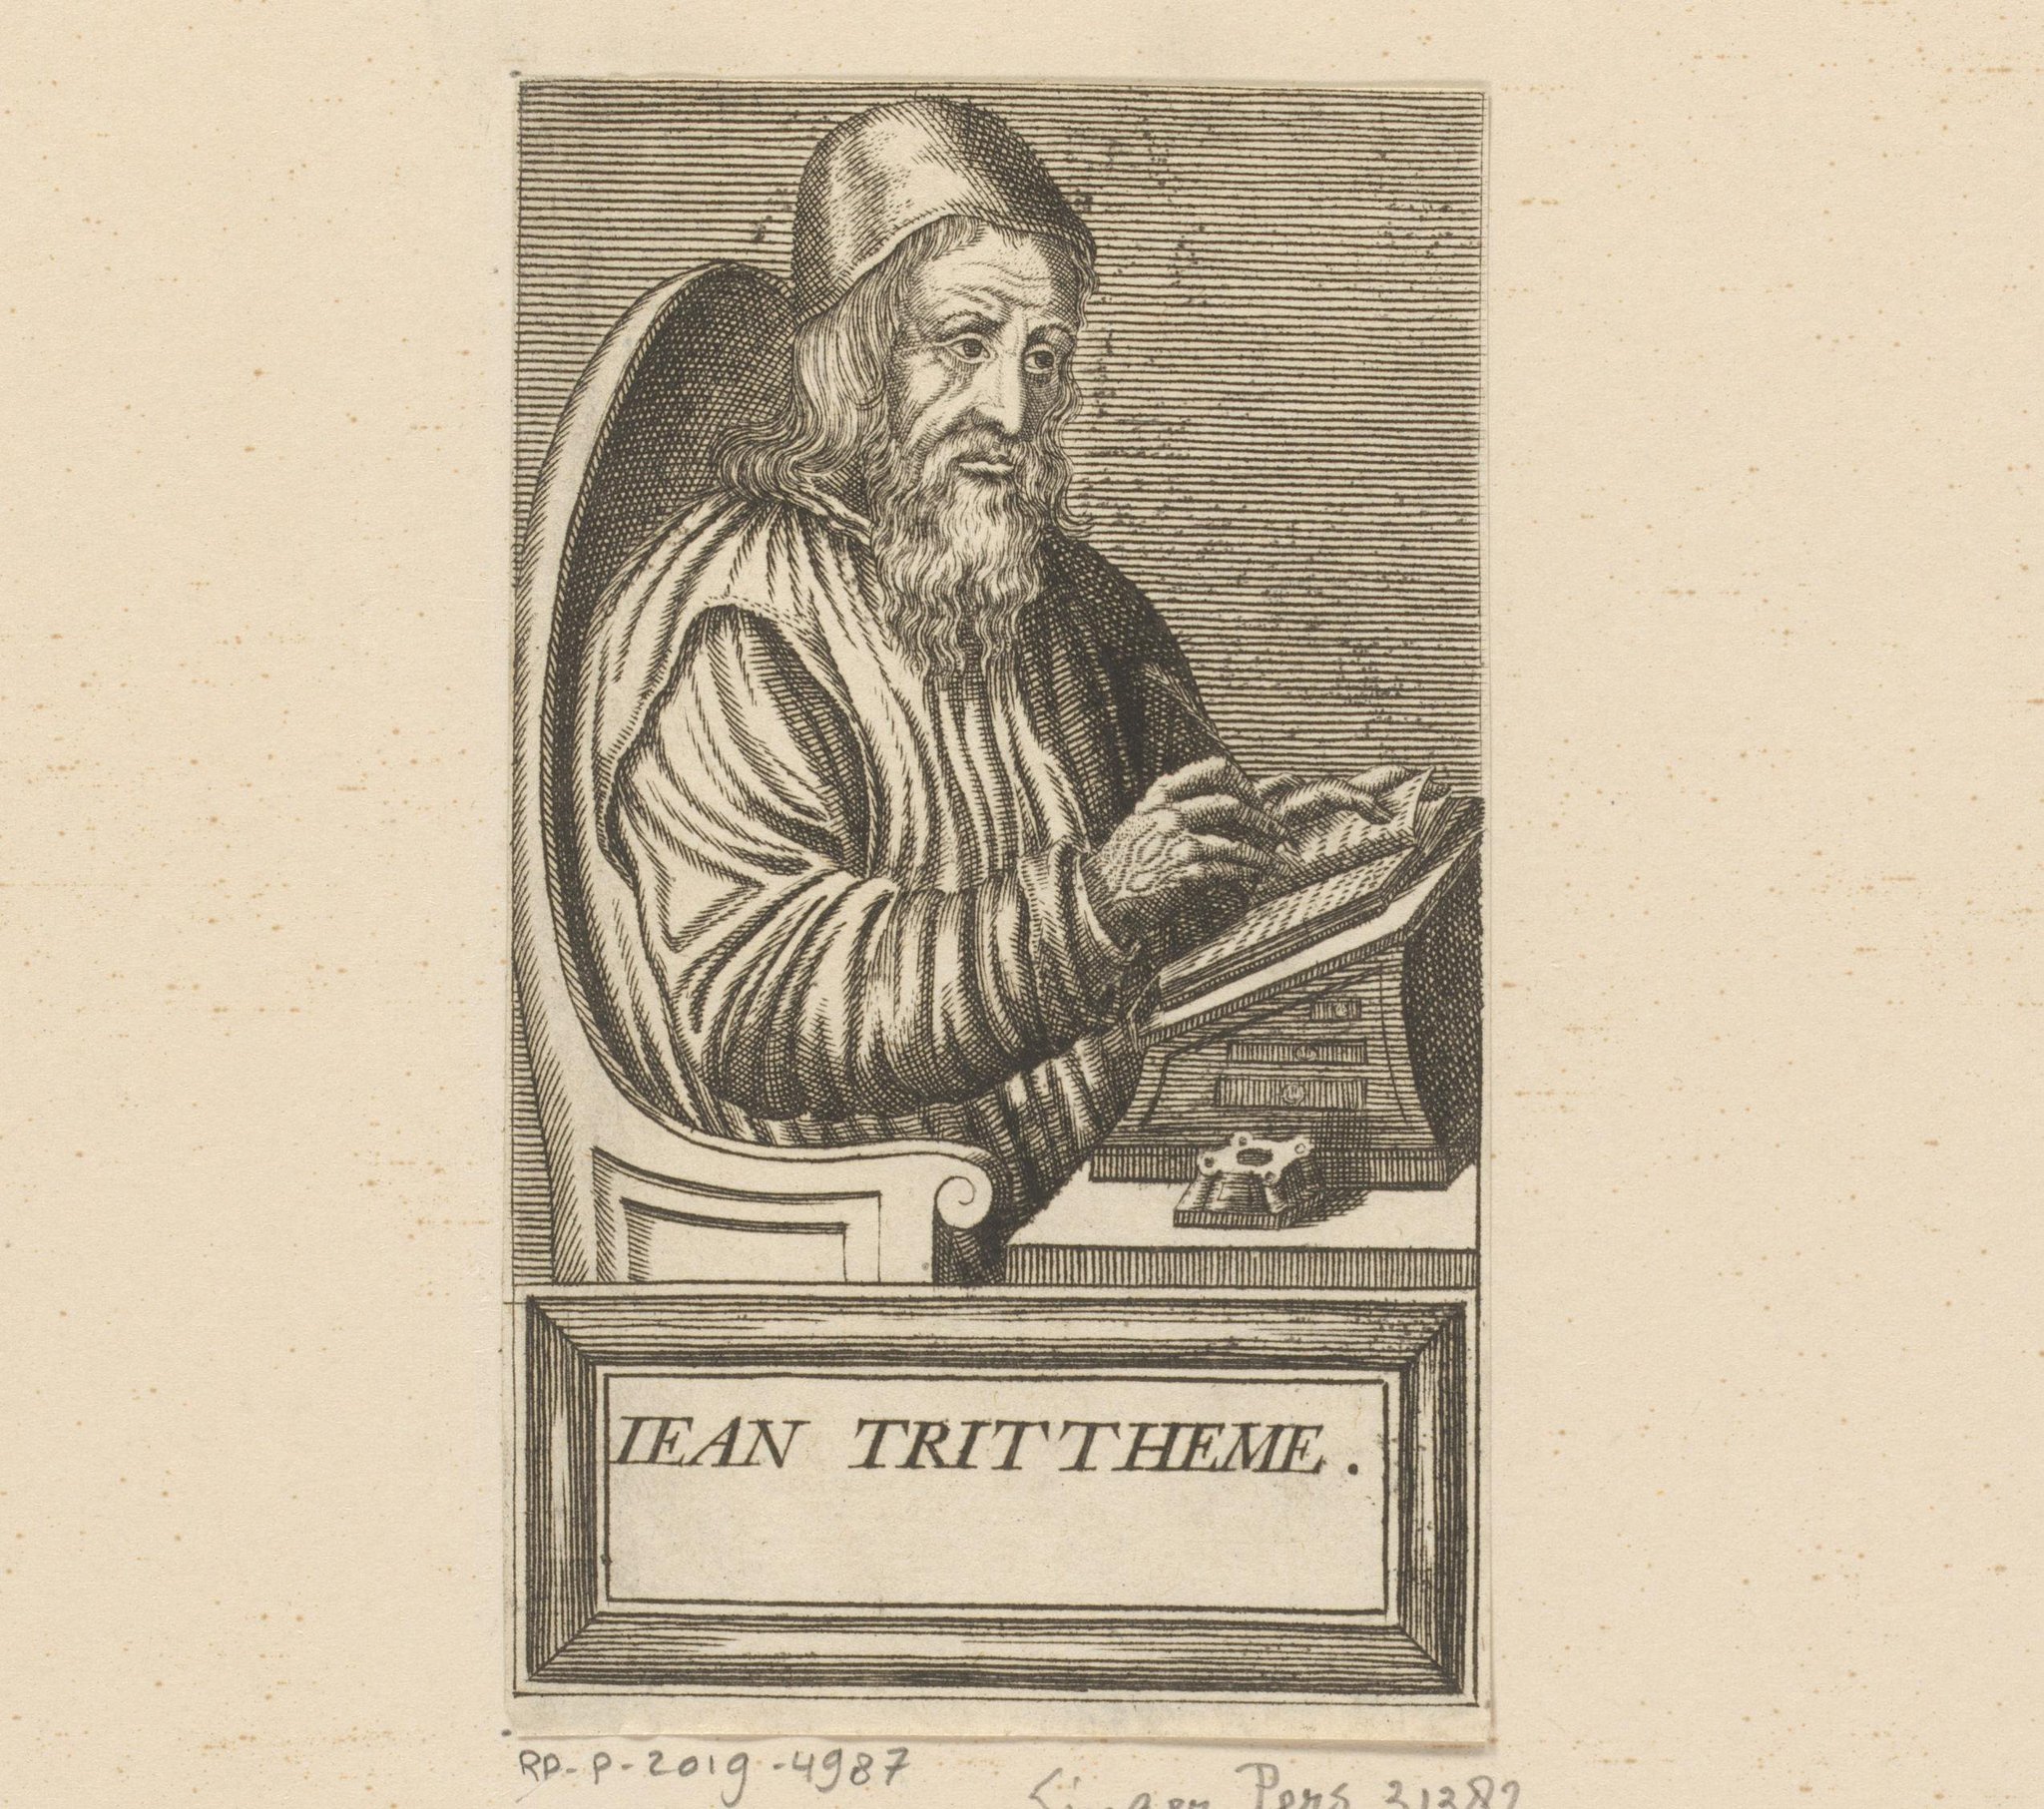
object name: print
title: Portret van Johannes Trithemius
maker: Anonymous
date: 1600-1649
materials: paper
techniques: engraving, etching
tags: historical persons, book